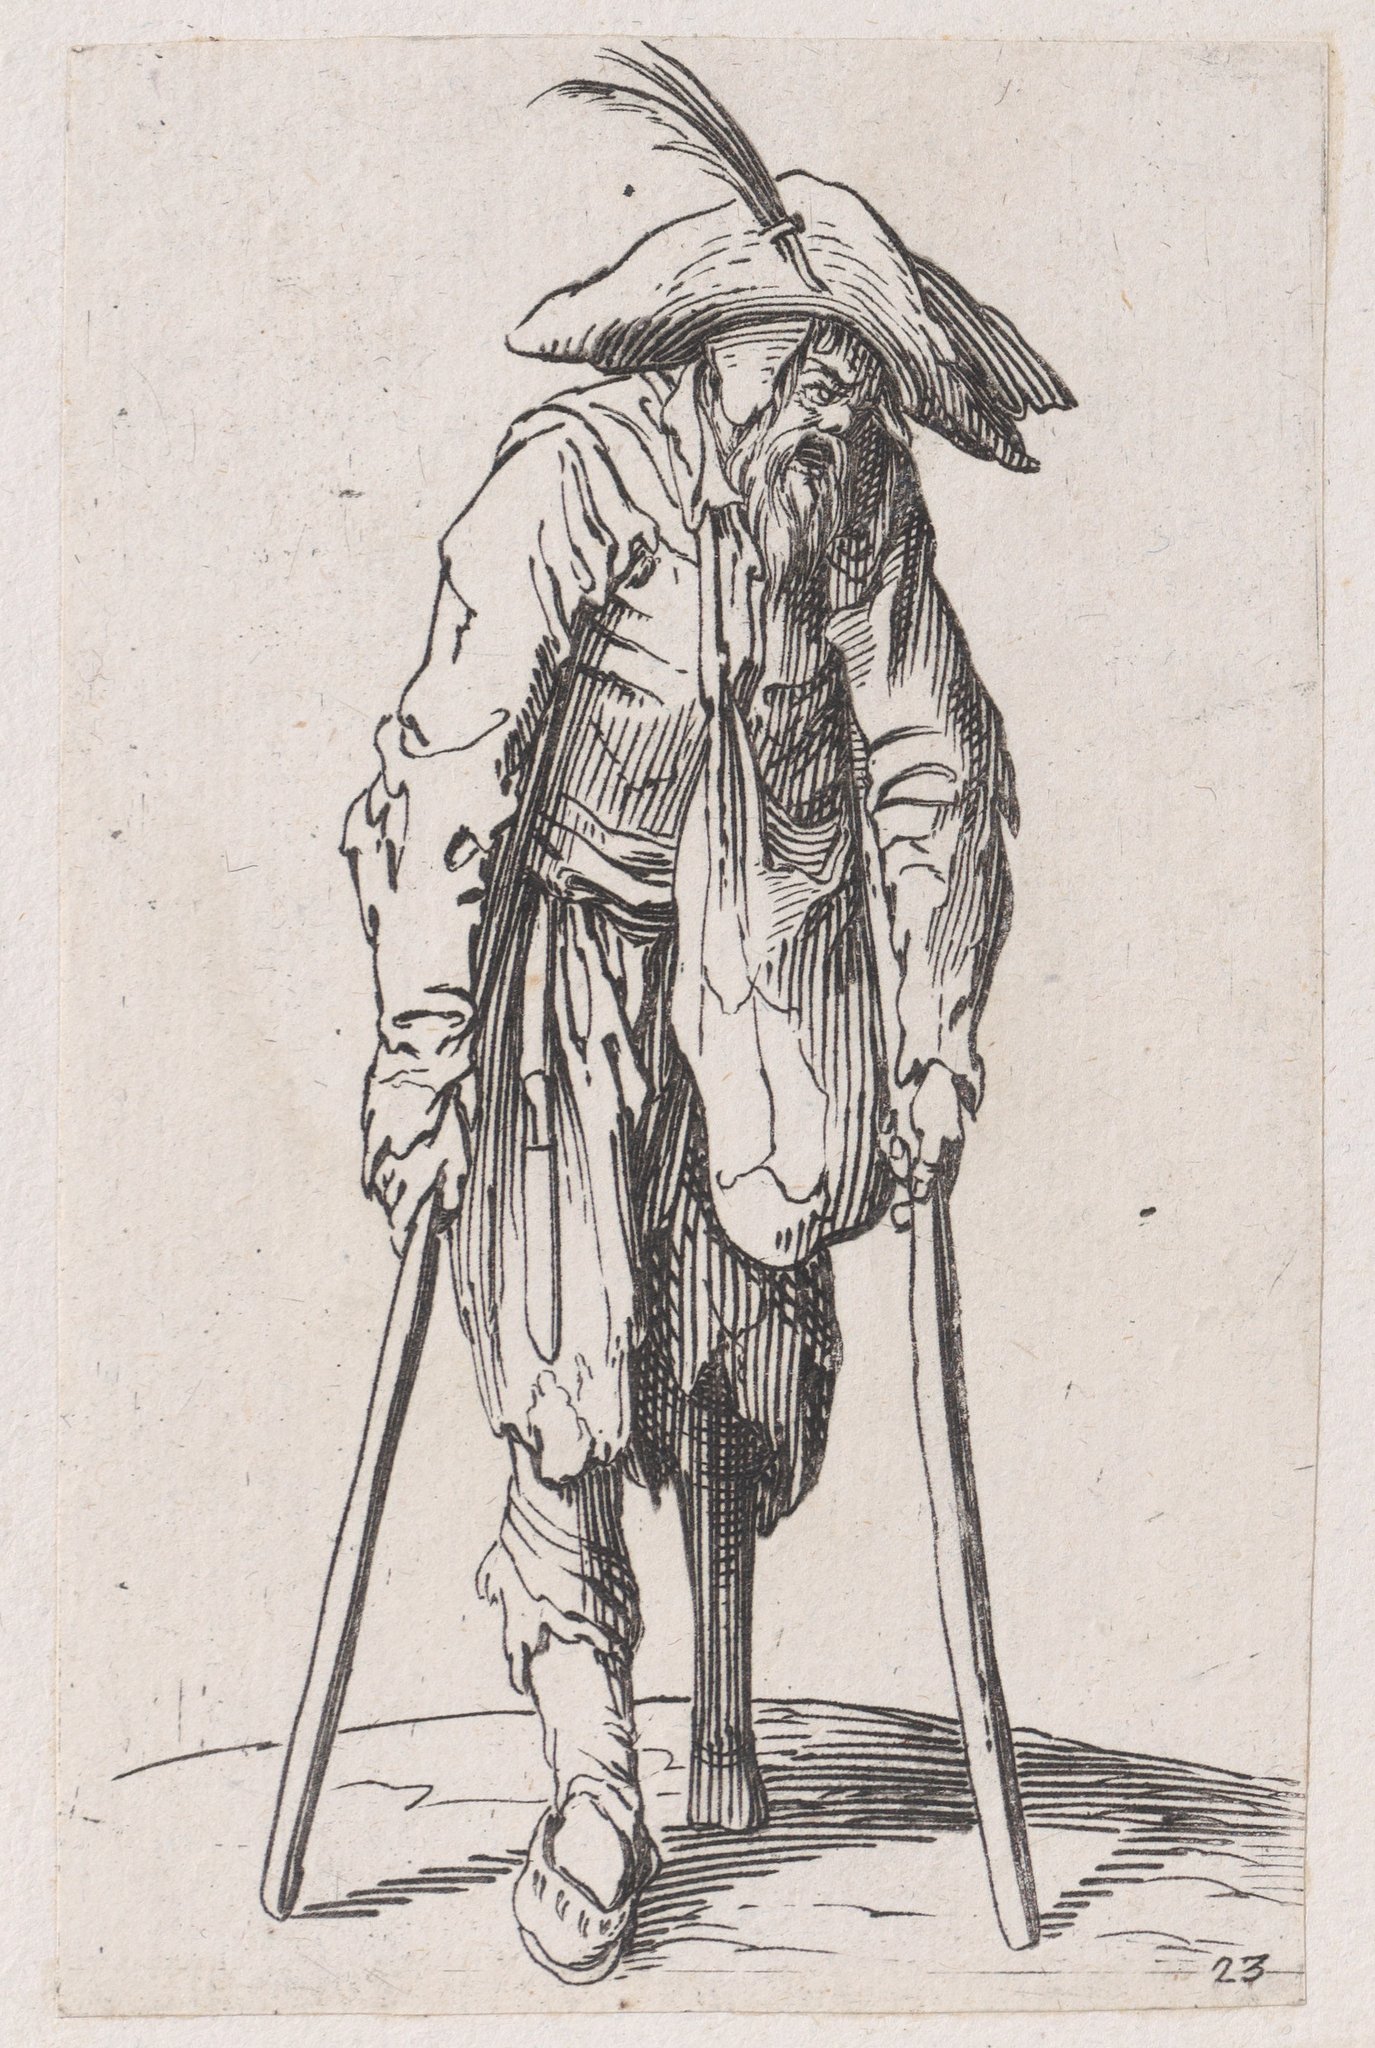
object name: print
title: Reverse Copy of Le Gentilhomme aux Mains Jointes (The Gentleman with his Hands Joined), from La Noblesse (The Nobility)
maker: Anonymous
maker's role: artist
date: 1601-1700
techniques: etching